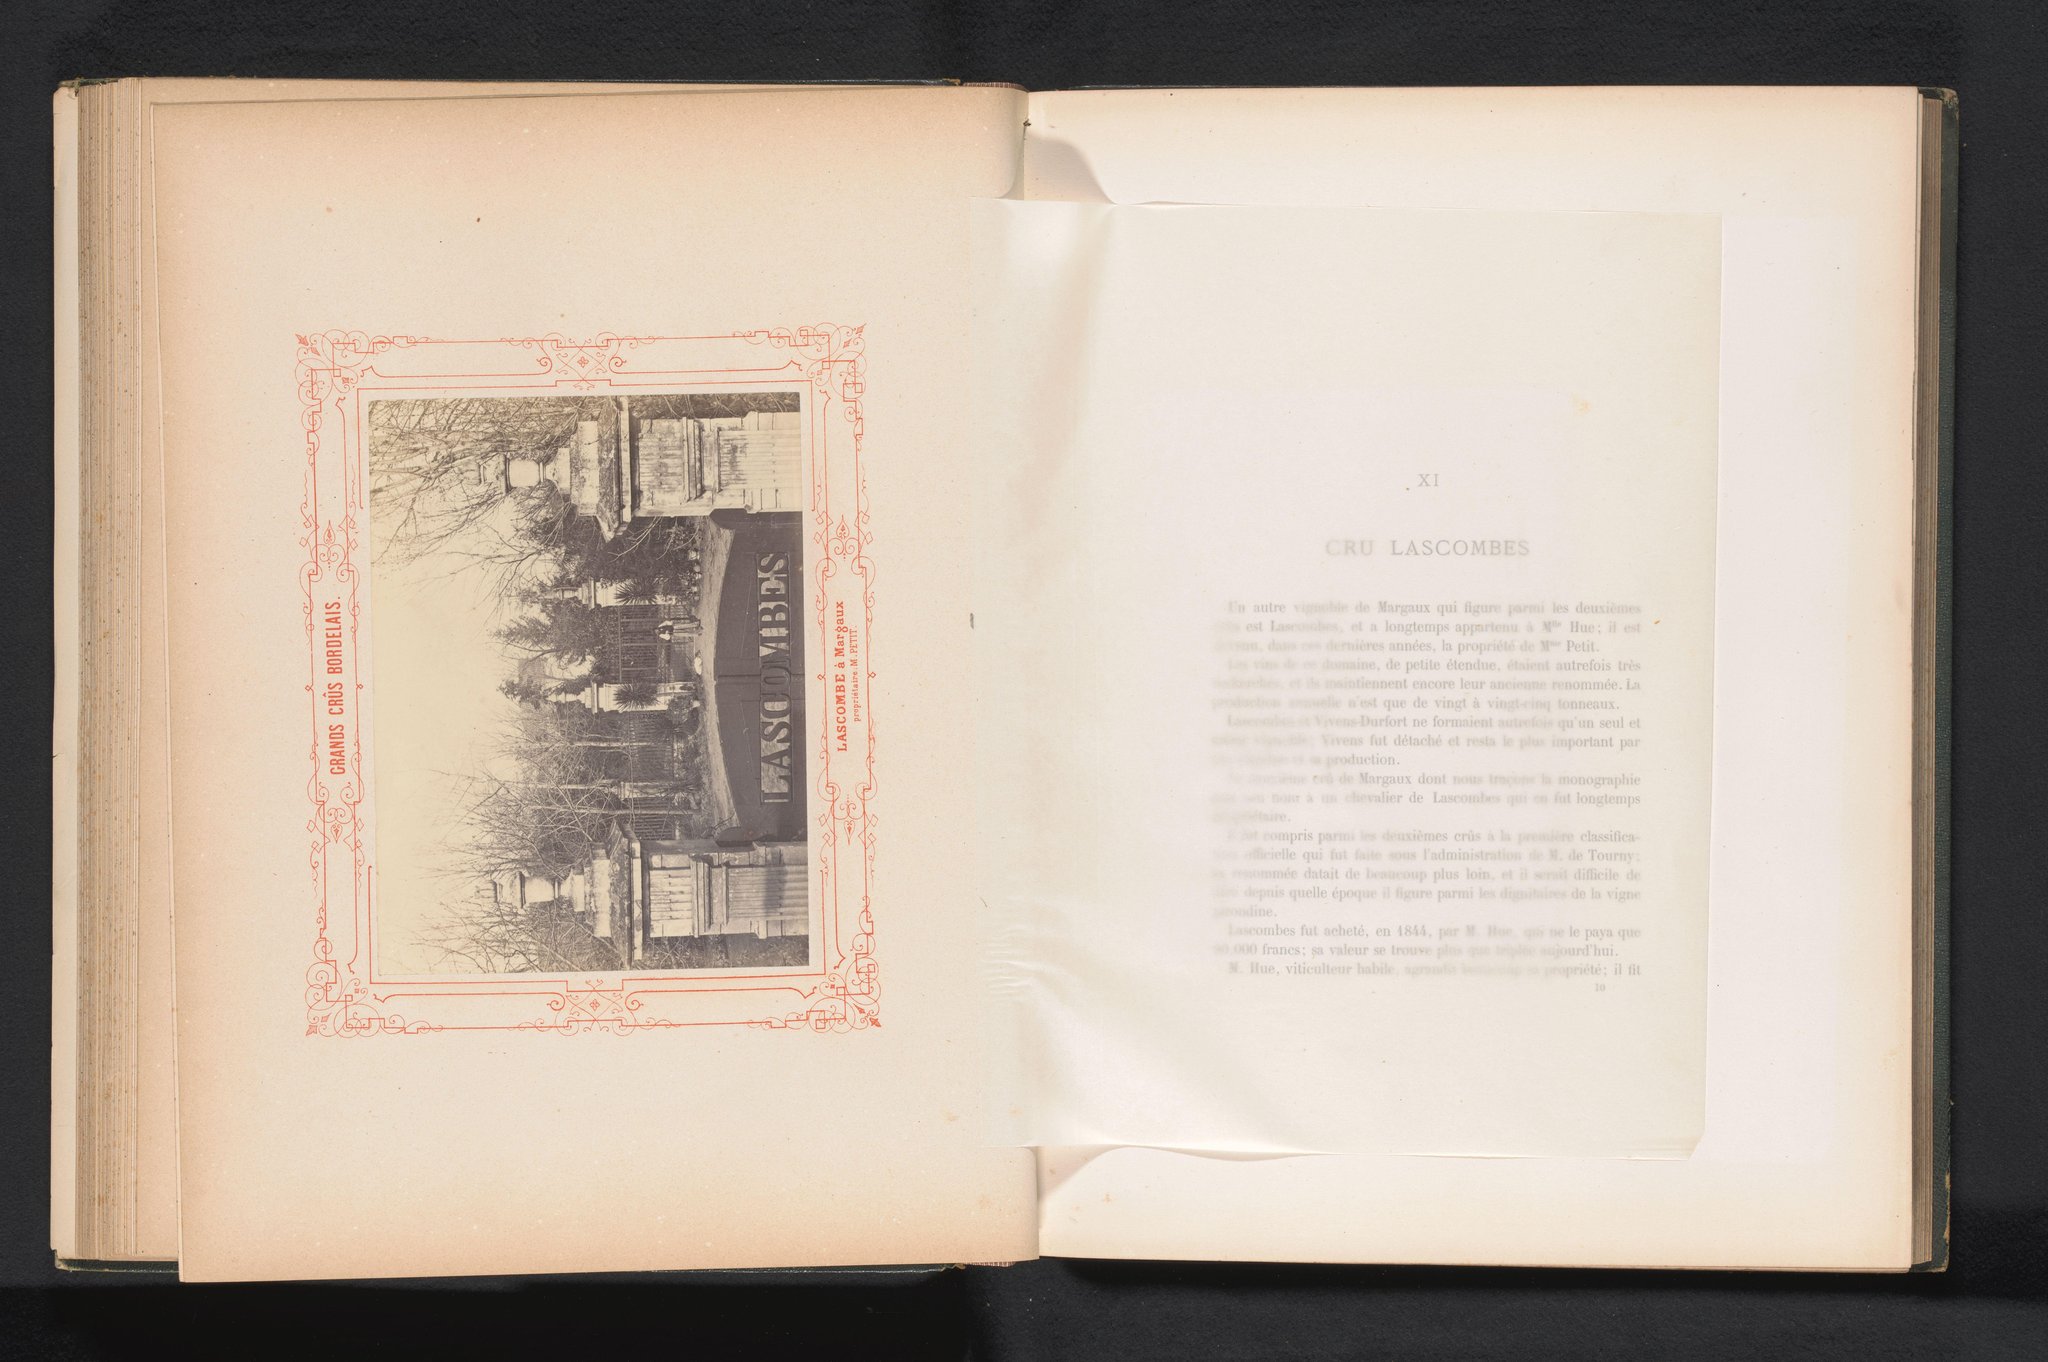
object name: photograph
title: Lacombes à Margaux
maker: alfred danflou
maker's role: fotograaf, schrijver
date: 1862-1867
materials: photographic support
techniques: albumen print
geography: margaux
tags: castle, gate, entrance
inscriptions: inscription: ‘propriétaire: M. PETIT.’